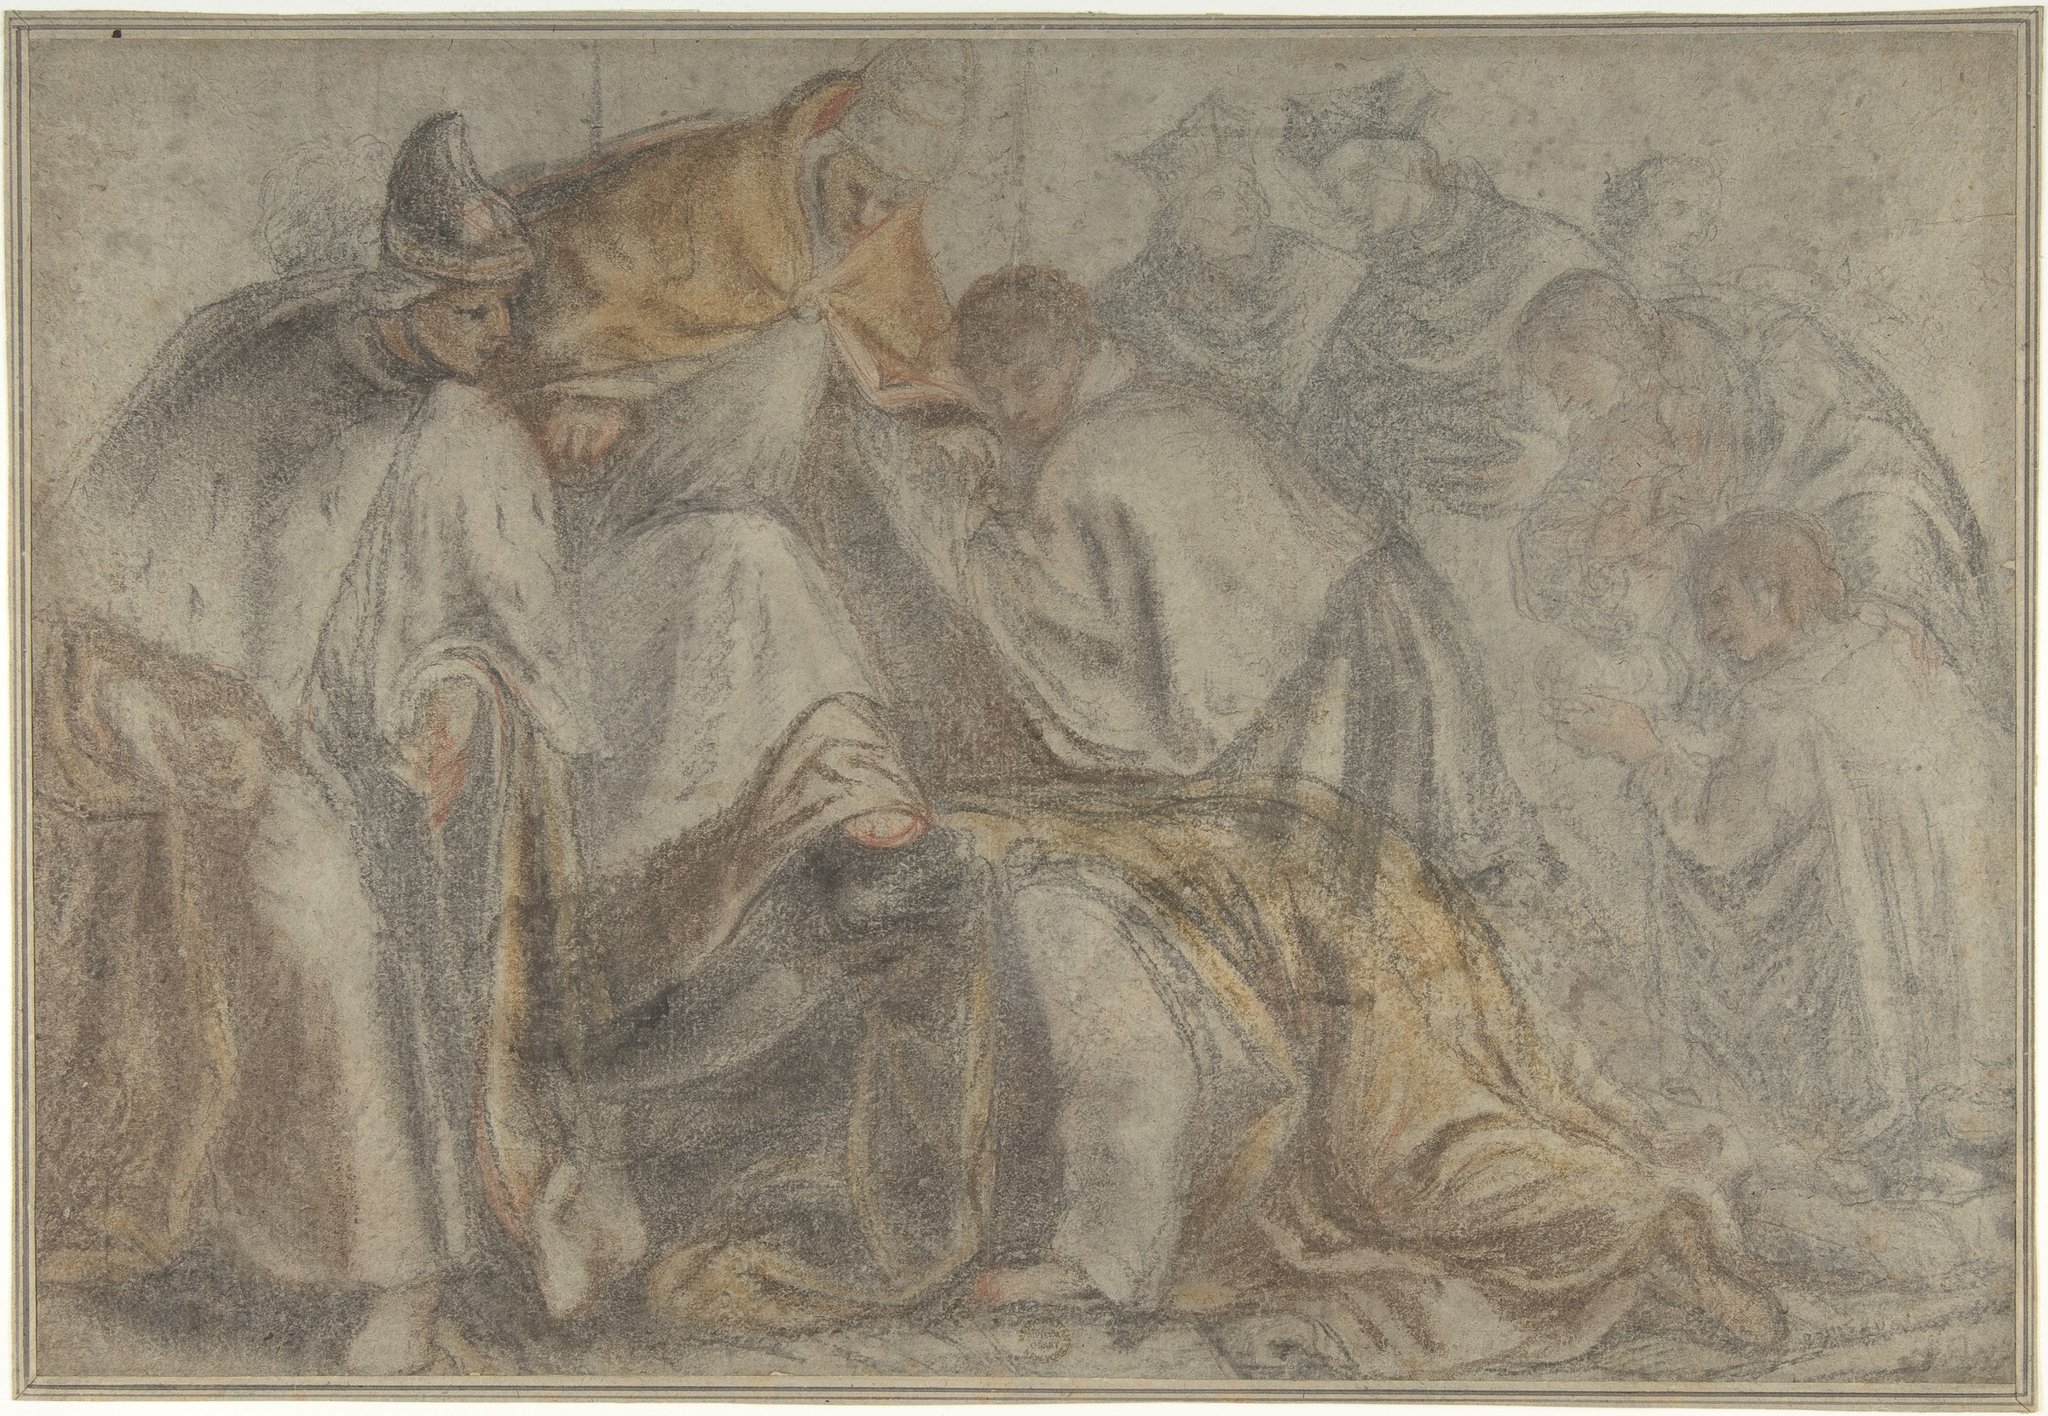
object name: drawing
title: The Emperor Frederick Barbarossa Submitting to Pope Alexander III in the Presence of a Doge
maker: pietro malombra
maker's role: artist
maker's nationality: italian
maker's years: 1556-1618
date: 1556-1618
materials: chalk, paper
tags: alexander the great,kings,men,popes